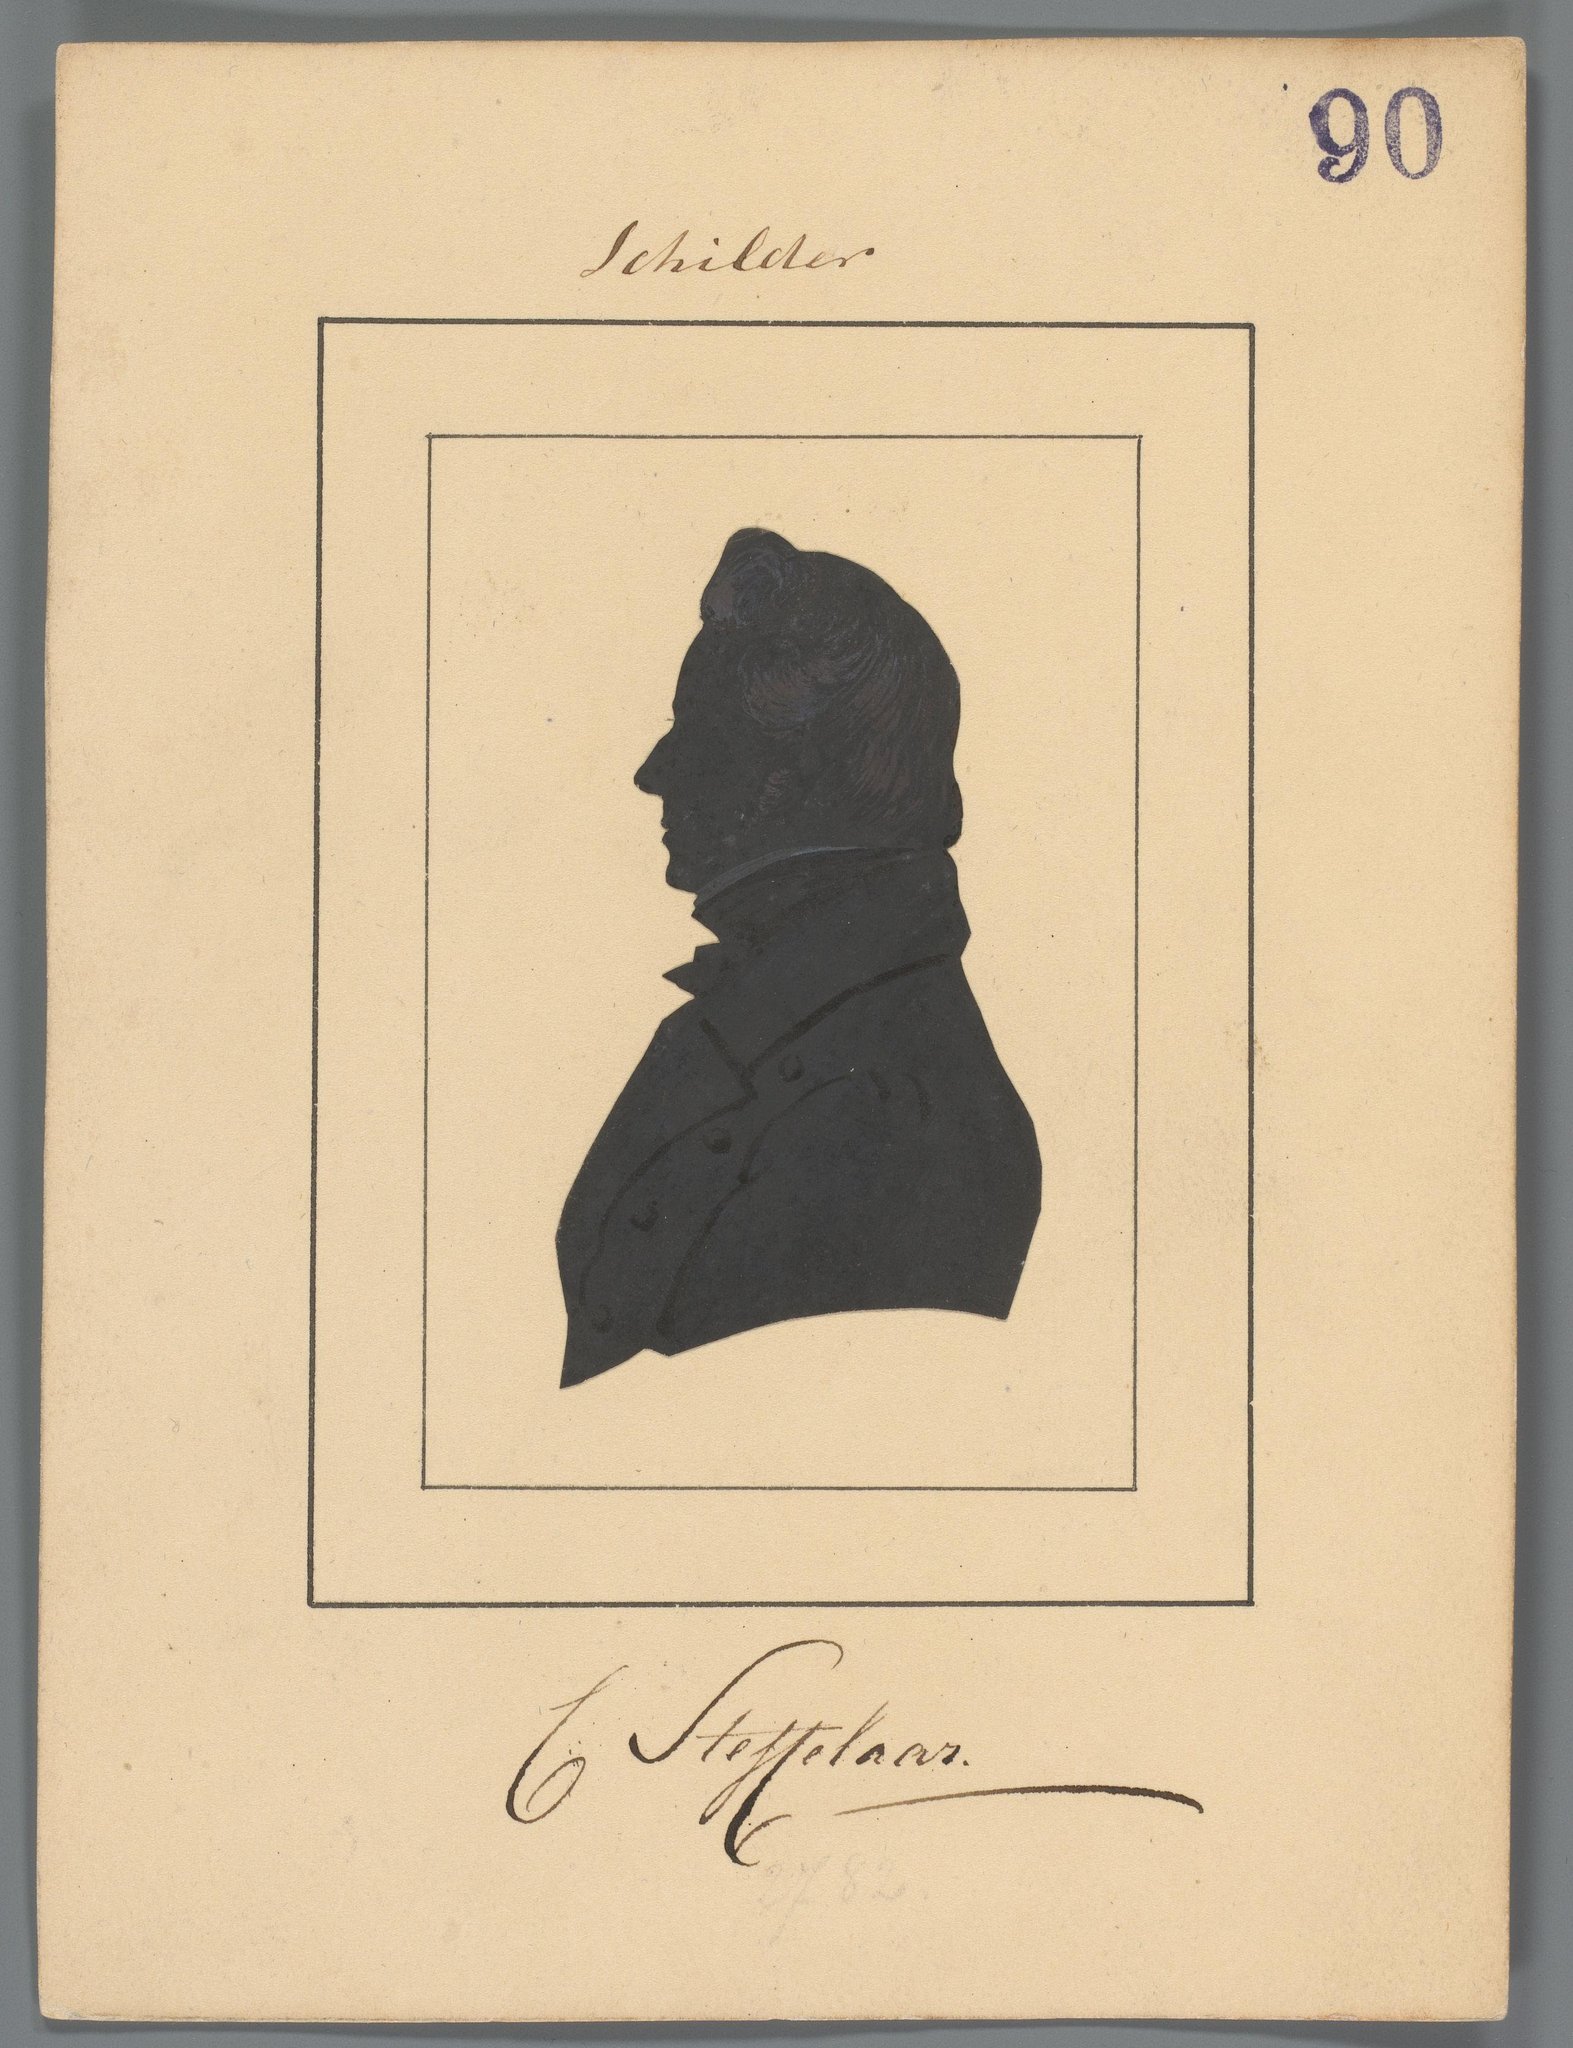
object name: drawing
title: Silhouetportret van Cornelis Steffelaar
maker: elisabeth alida haanen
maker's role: draughtsman, print maker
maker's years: 1809-1845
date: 1819-1845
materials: ink, paint, paper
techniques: brush, snipping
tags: painter, cornelis steffelaar, historical persons, portrait, self-portrait of painter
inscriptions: inscription: ‘C Steffelaar.’, number: ‘90’, collector's mark: ‘Ex-libris van Beresteyn’, number: ‘13928’, inscription: ‘Schilder’, inscription: ‘Neg. D. 1721’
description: Met onder het portret de handtekening van de geportretteerde.